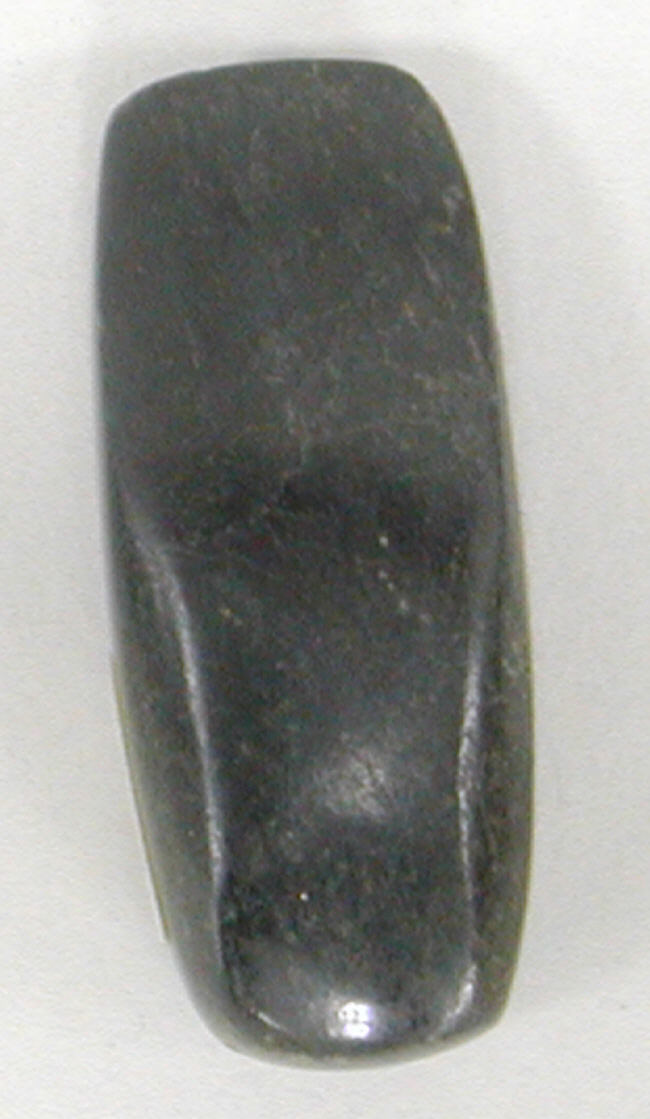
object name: celt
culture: maya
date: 1501-1600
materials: stone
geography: guatemala